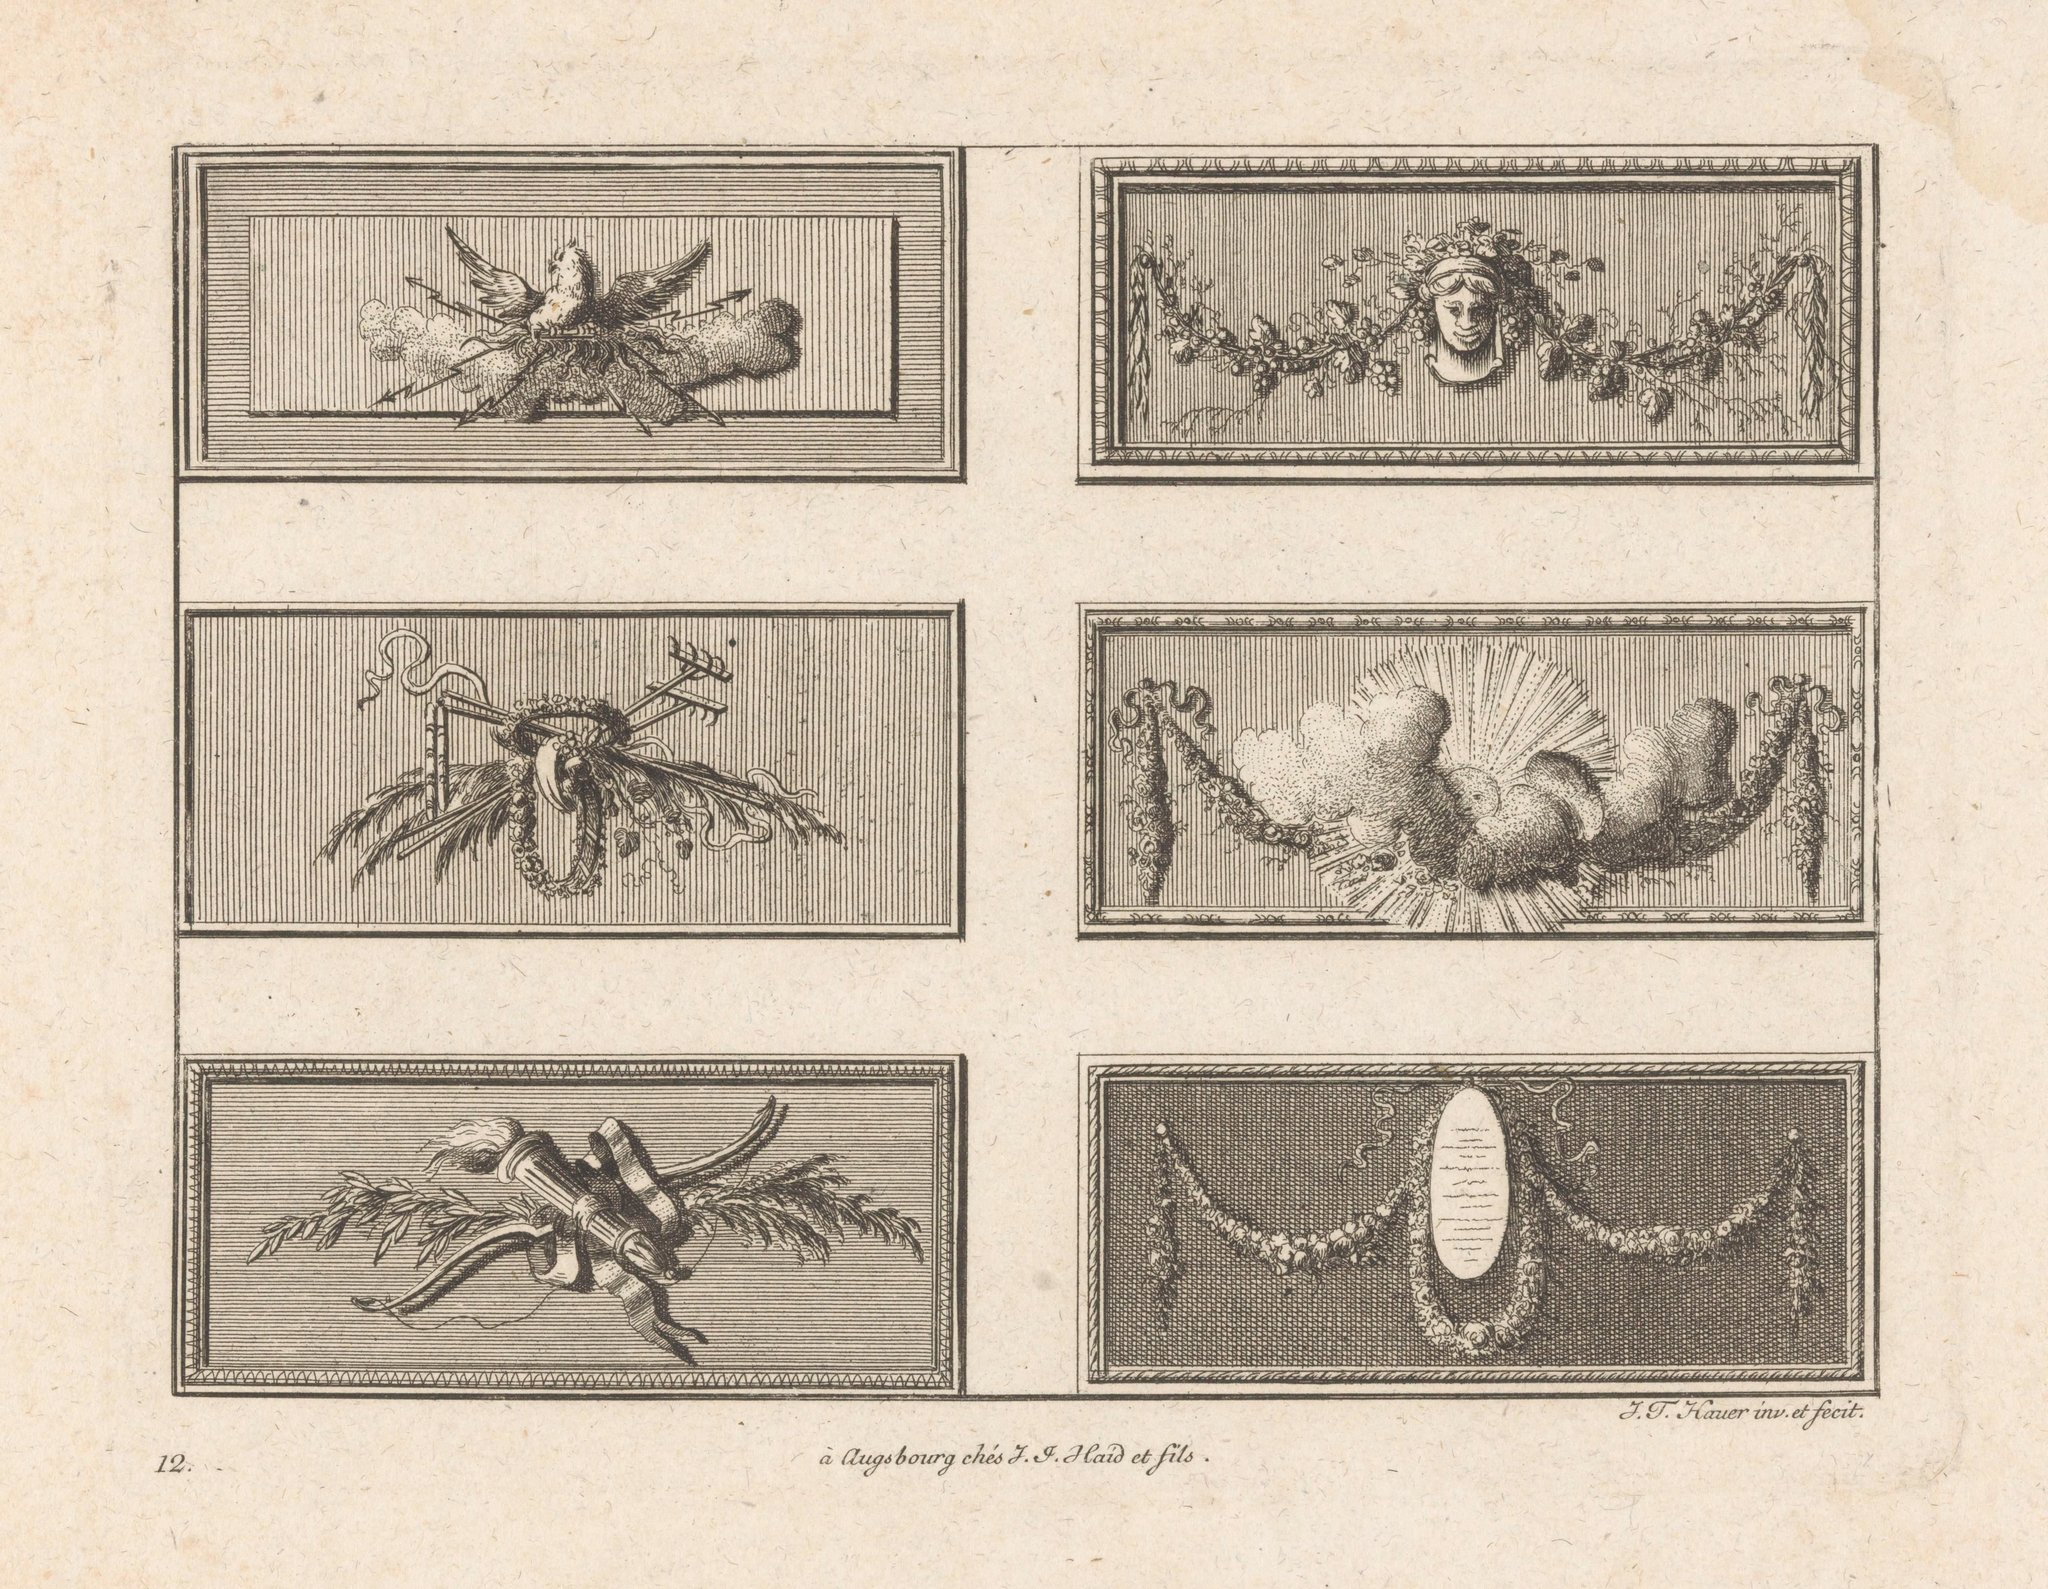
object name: print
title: Zes trofeeën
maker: johann thomas hauer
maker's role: print maker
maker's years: 1748-1820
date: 1758-1820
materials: paper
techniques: engraving, etching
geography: augsburg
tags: trophy, i.e.: decorative arrangement of symbolic or typical objects ~ ornament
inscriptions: collector's mark: Lugt 2228, collector's mark: Lugt 2760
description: Ontwerpen voor zes rechthoekige trofeeën. Links boven een adelaar met bliksemschichten, rechts boven een kop met druivenranken, links in het midden agrarische objecten, rechts in het midden de zon en guirlandes, links onder een fakkel en een boog, rechts onder een ovaal medaillon en guirlandes.